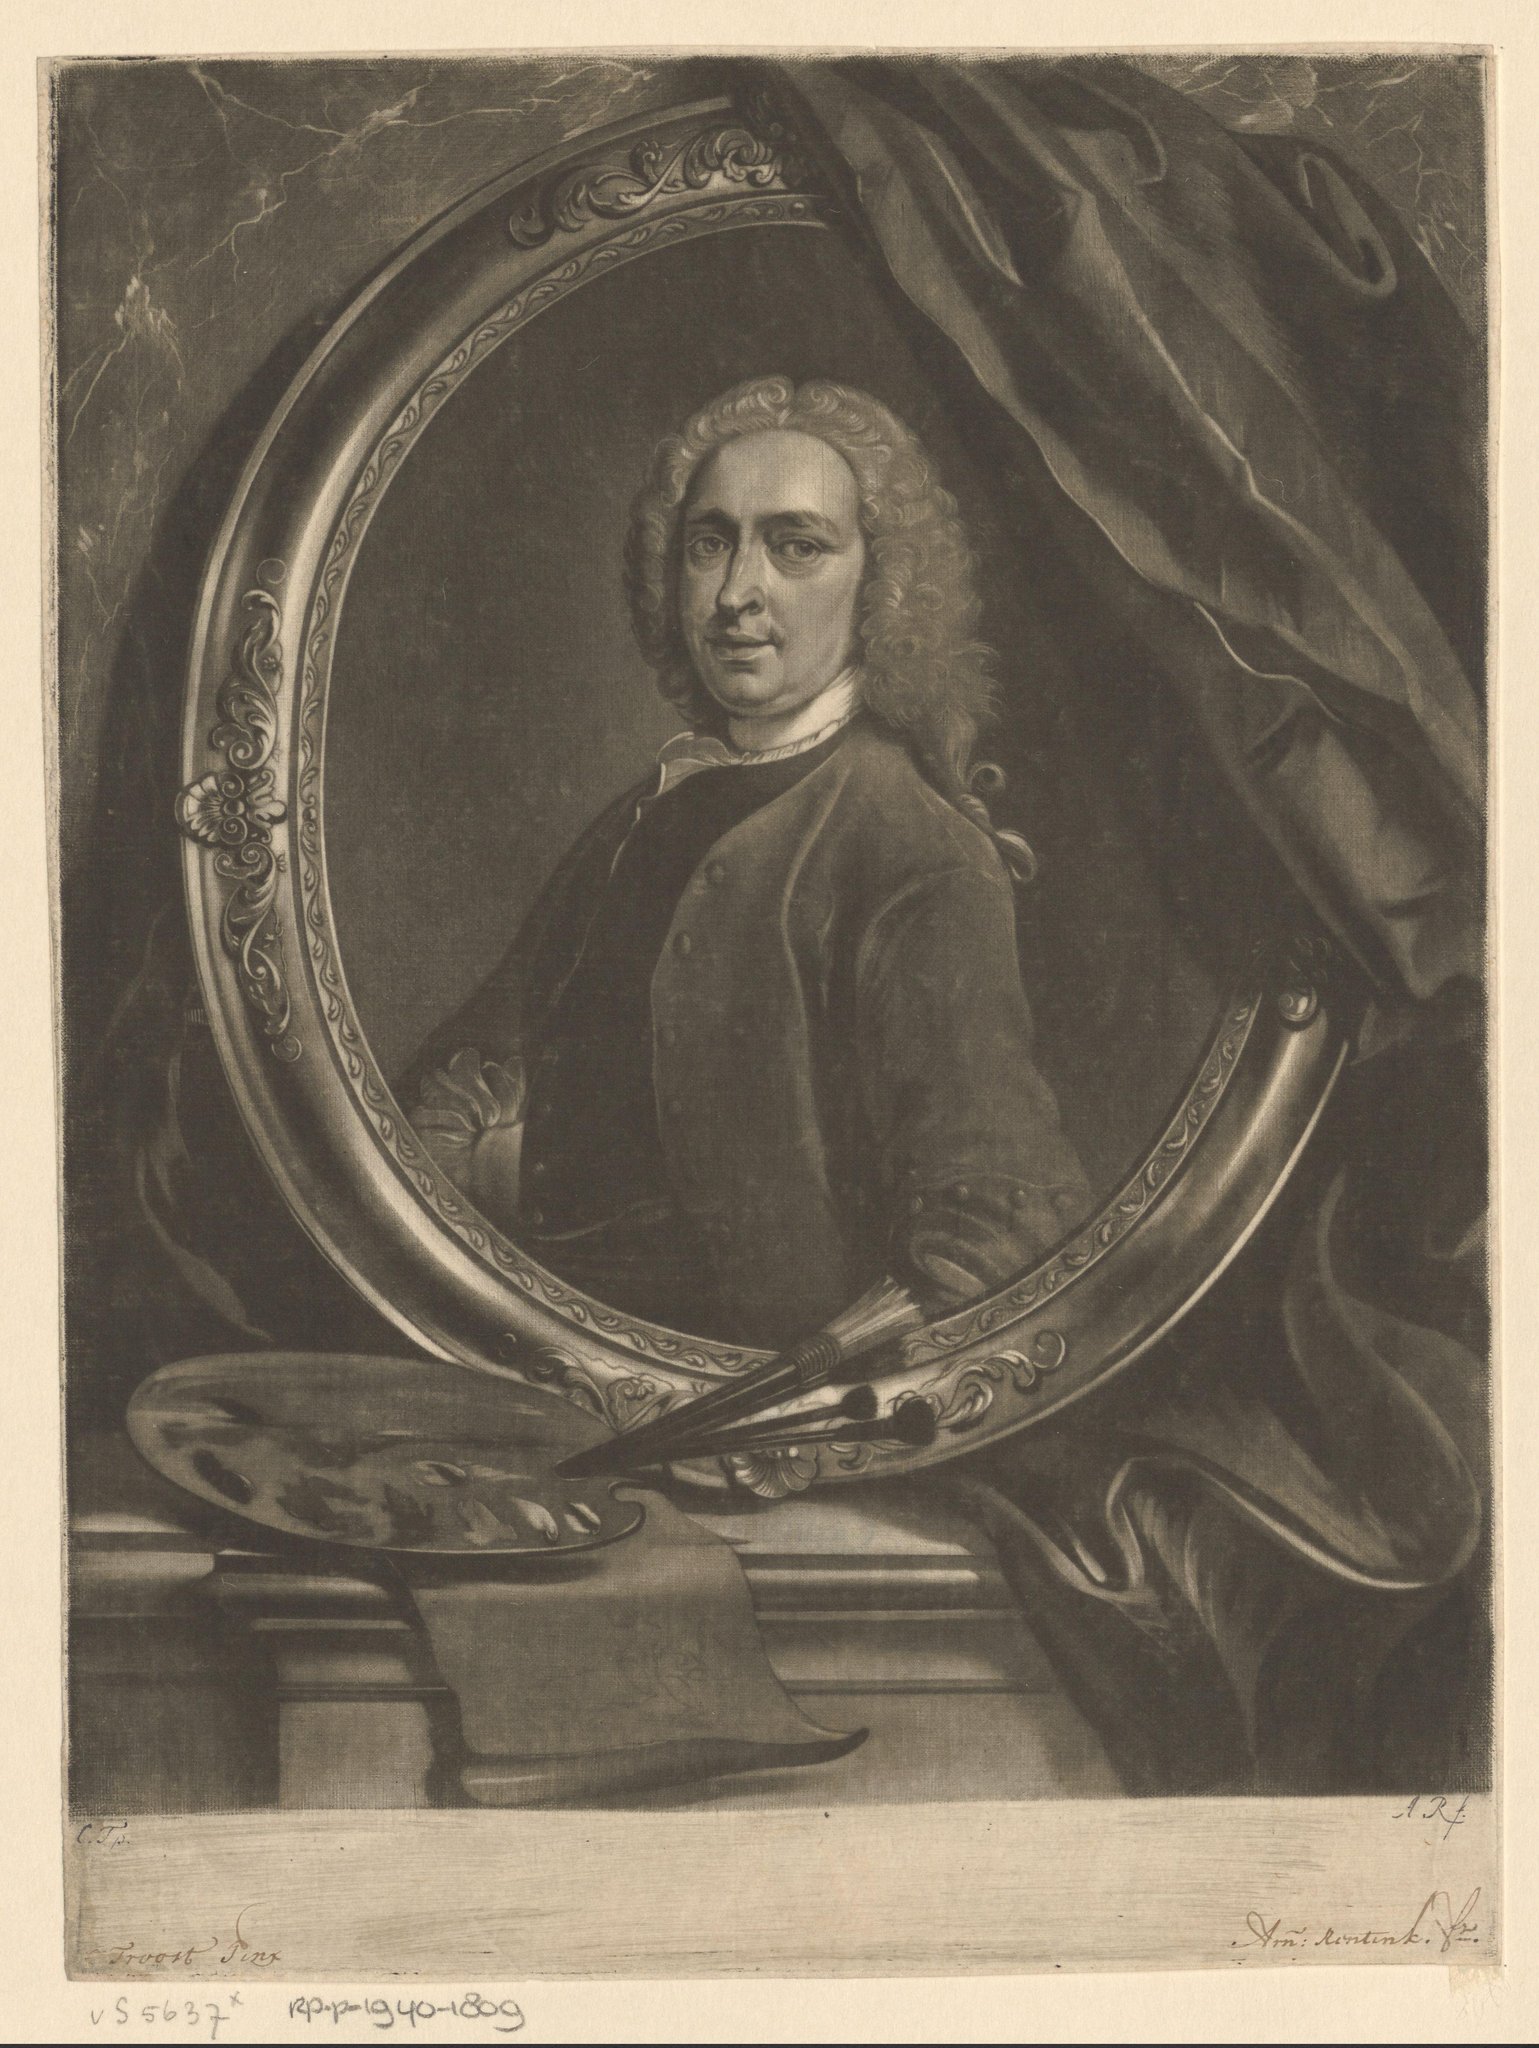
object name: print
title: Portret van Cornelis Troost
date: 1739-1775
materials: paper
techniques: mezzotint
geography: amsterdam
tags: amsterdam, painter, print maker, draughtsman, cornelis troost, historical persons, portrait, self-portrait of painter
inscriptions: signature: ‘Arn : Rentink. Sc.’, collector's mark: Lugt 2760, signature: ‘Troost Pinx’, collector's mark: Lugt 2228